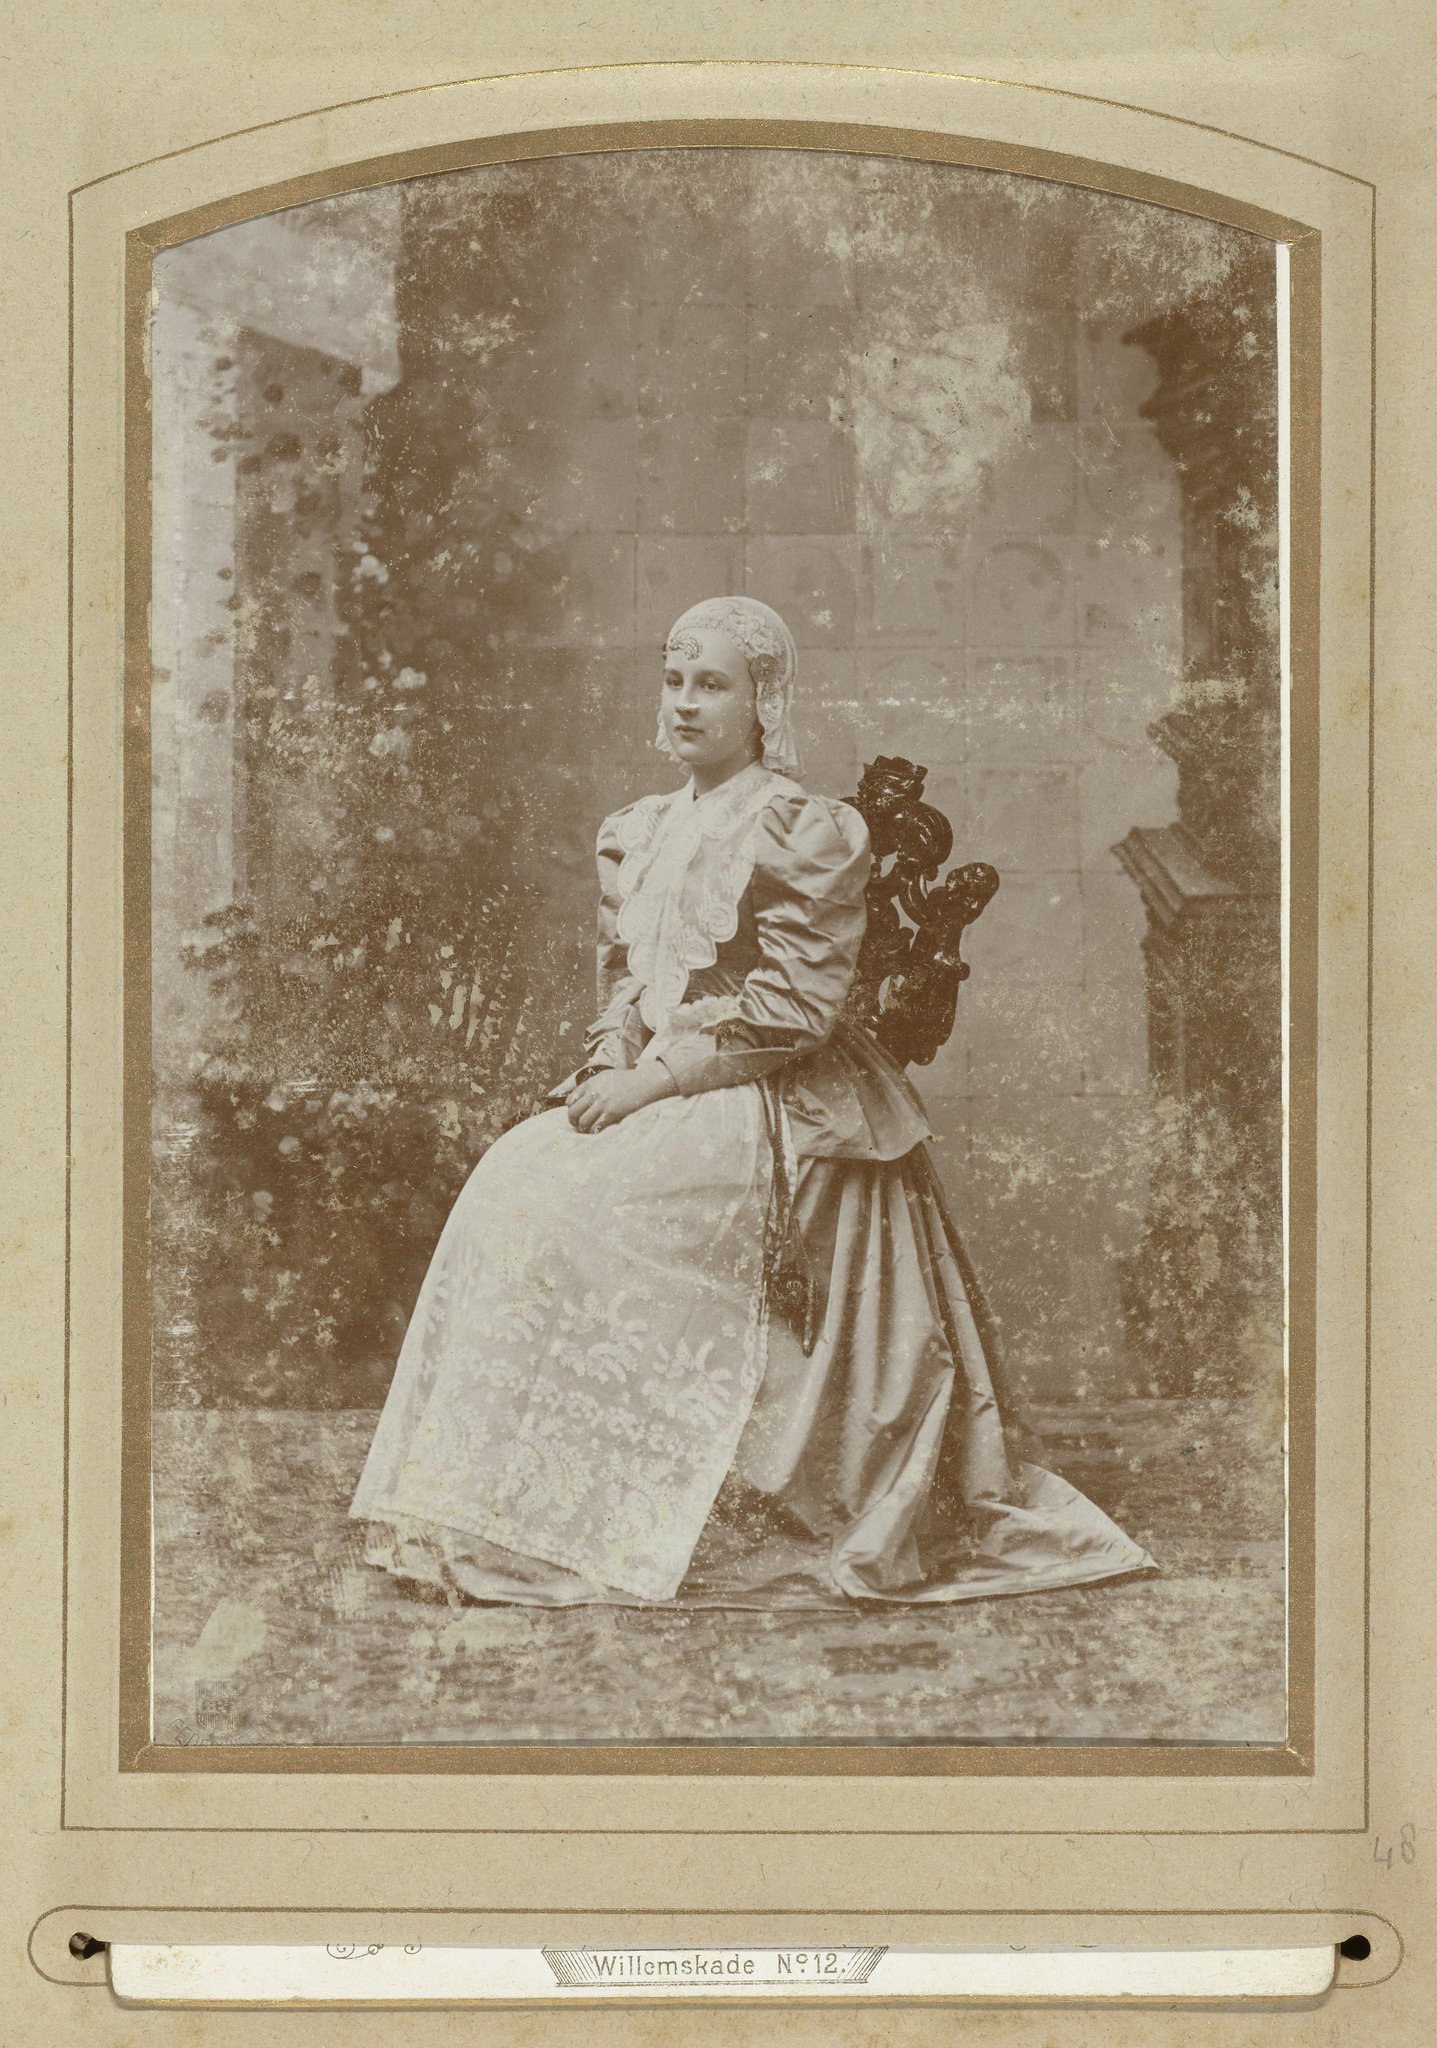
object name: photograph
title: Portret van koningin Wilhelmina in Friese klederdracht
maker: cornelis bernardus broersma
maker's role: fotograaf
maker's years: 1841-1919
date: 1892-1903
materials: paper, photographic support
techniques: photography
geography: leeuwarden